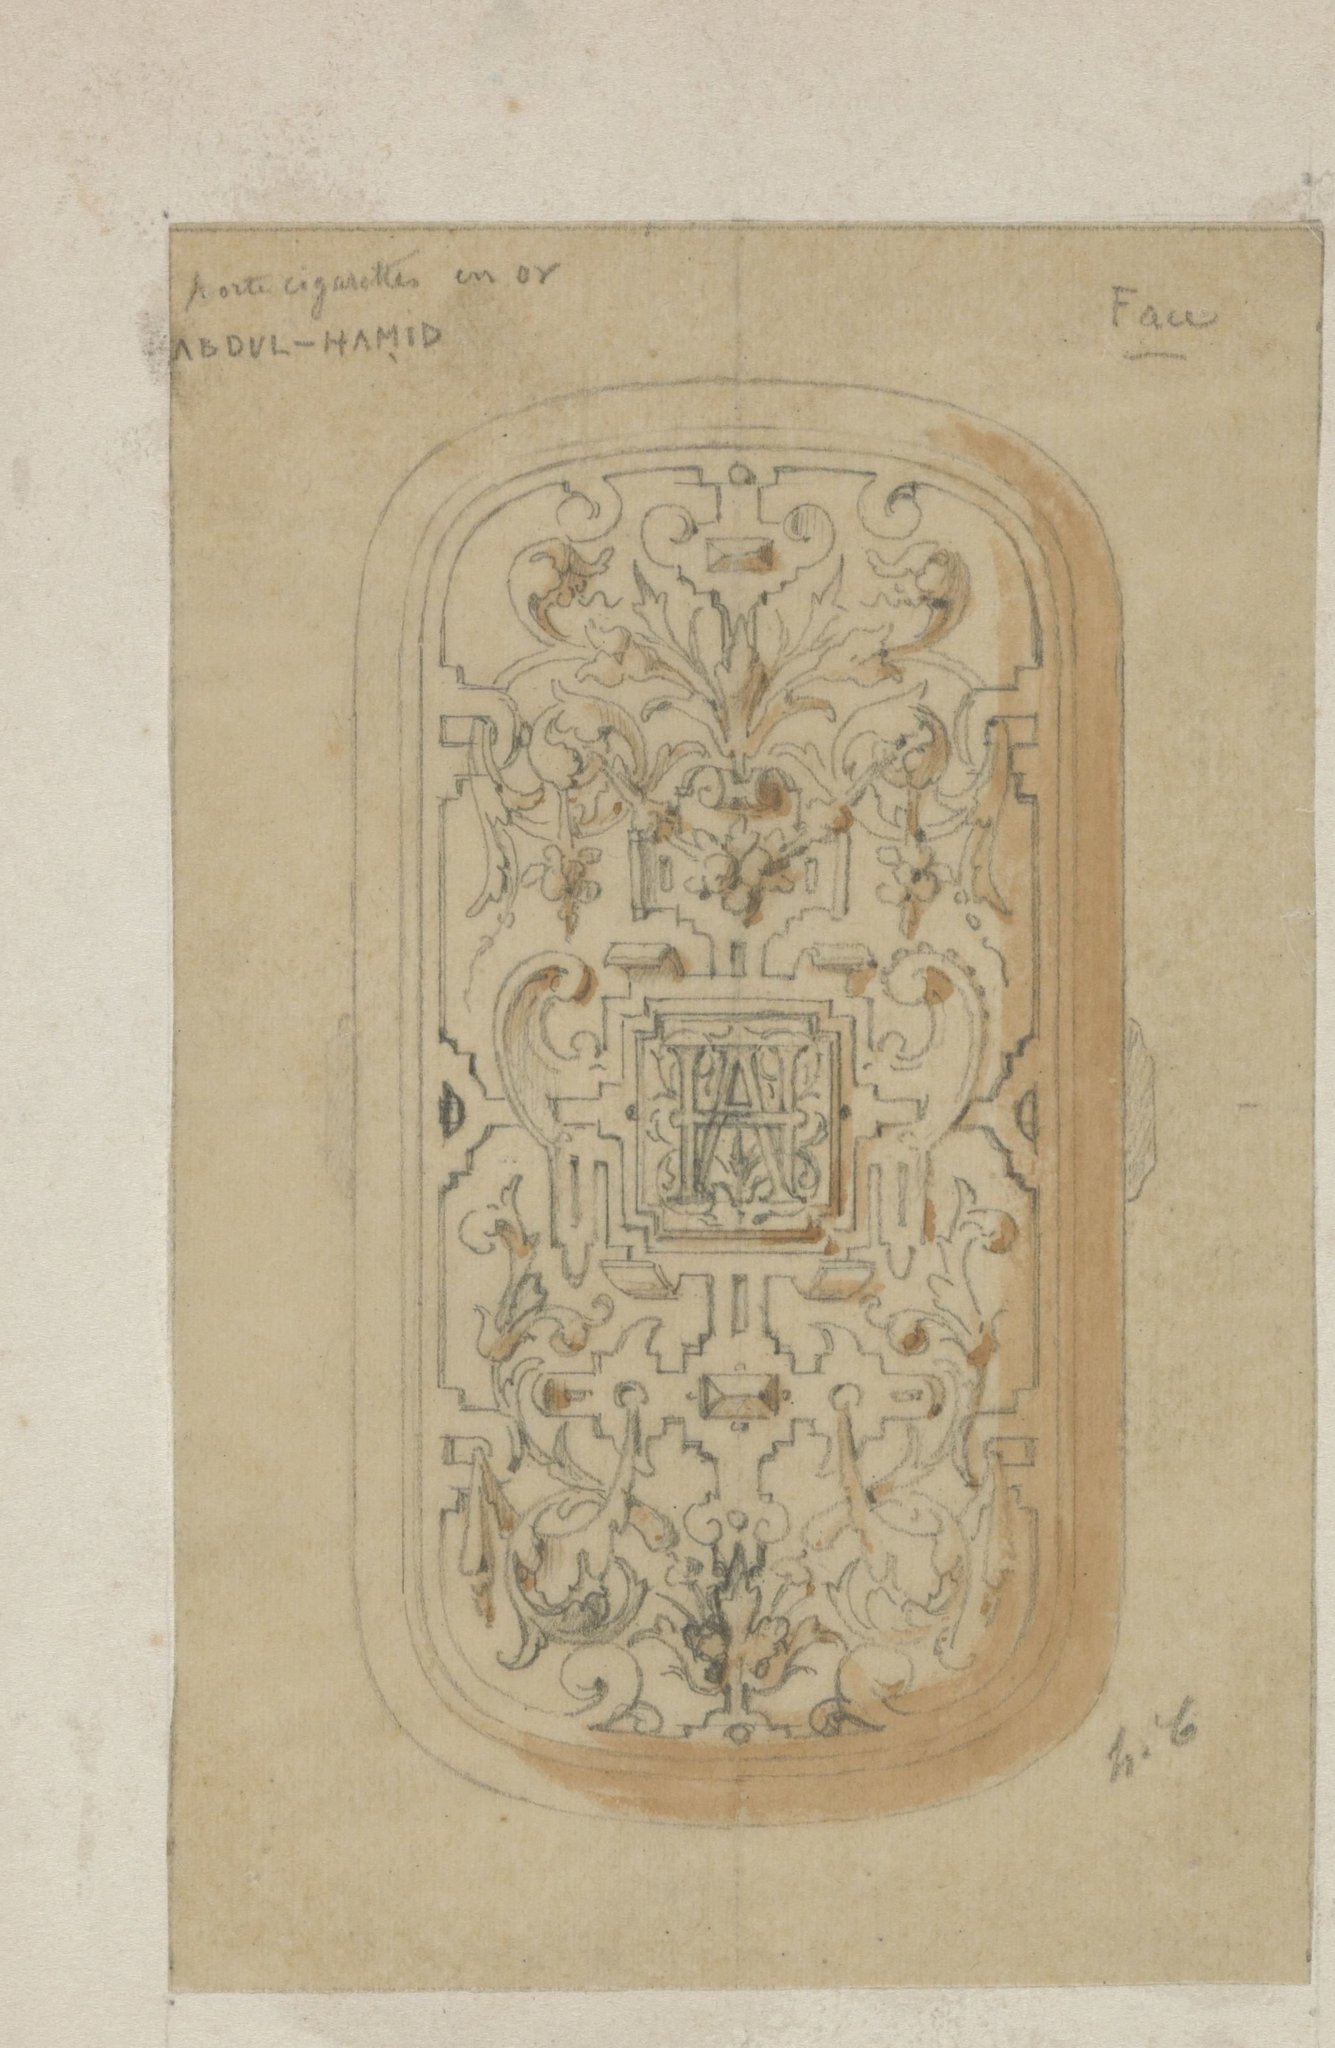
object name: design drawing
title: Ontwerp voor sigarettenétui met monogram AH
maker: henri cameré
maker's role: designer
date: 1864-1894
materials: pencil, paper, watercolor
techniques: brush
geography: paris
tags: cigarette-case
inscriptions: signature: ‘h.C.’, caption: ‘Porte-cigarettes en or massif pour le Sultan Abdul-Hamid II de Turquie’, inscription: ‘porte cigarettes en or / ABDUL-HAMID / Face’